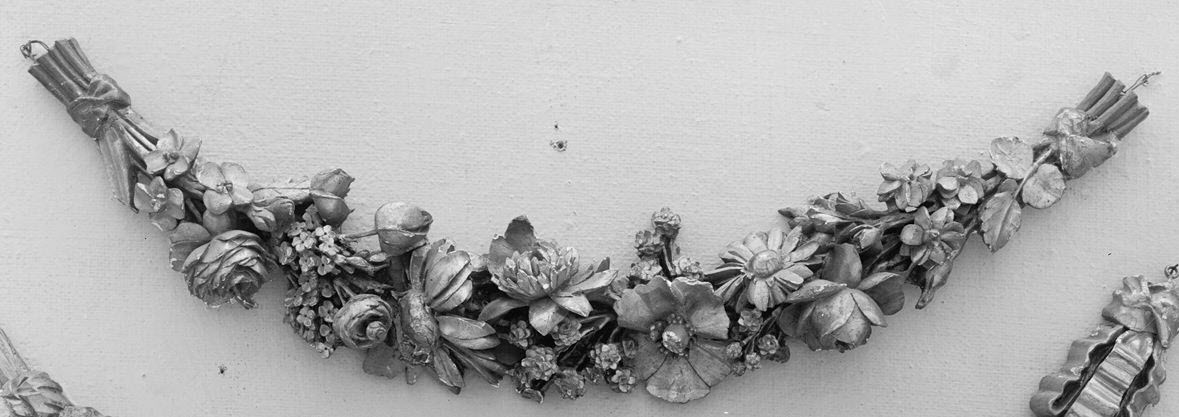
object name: garland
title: Garland (part of a set)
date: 1701-1800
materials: gilt, wood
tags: garlands,flowers